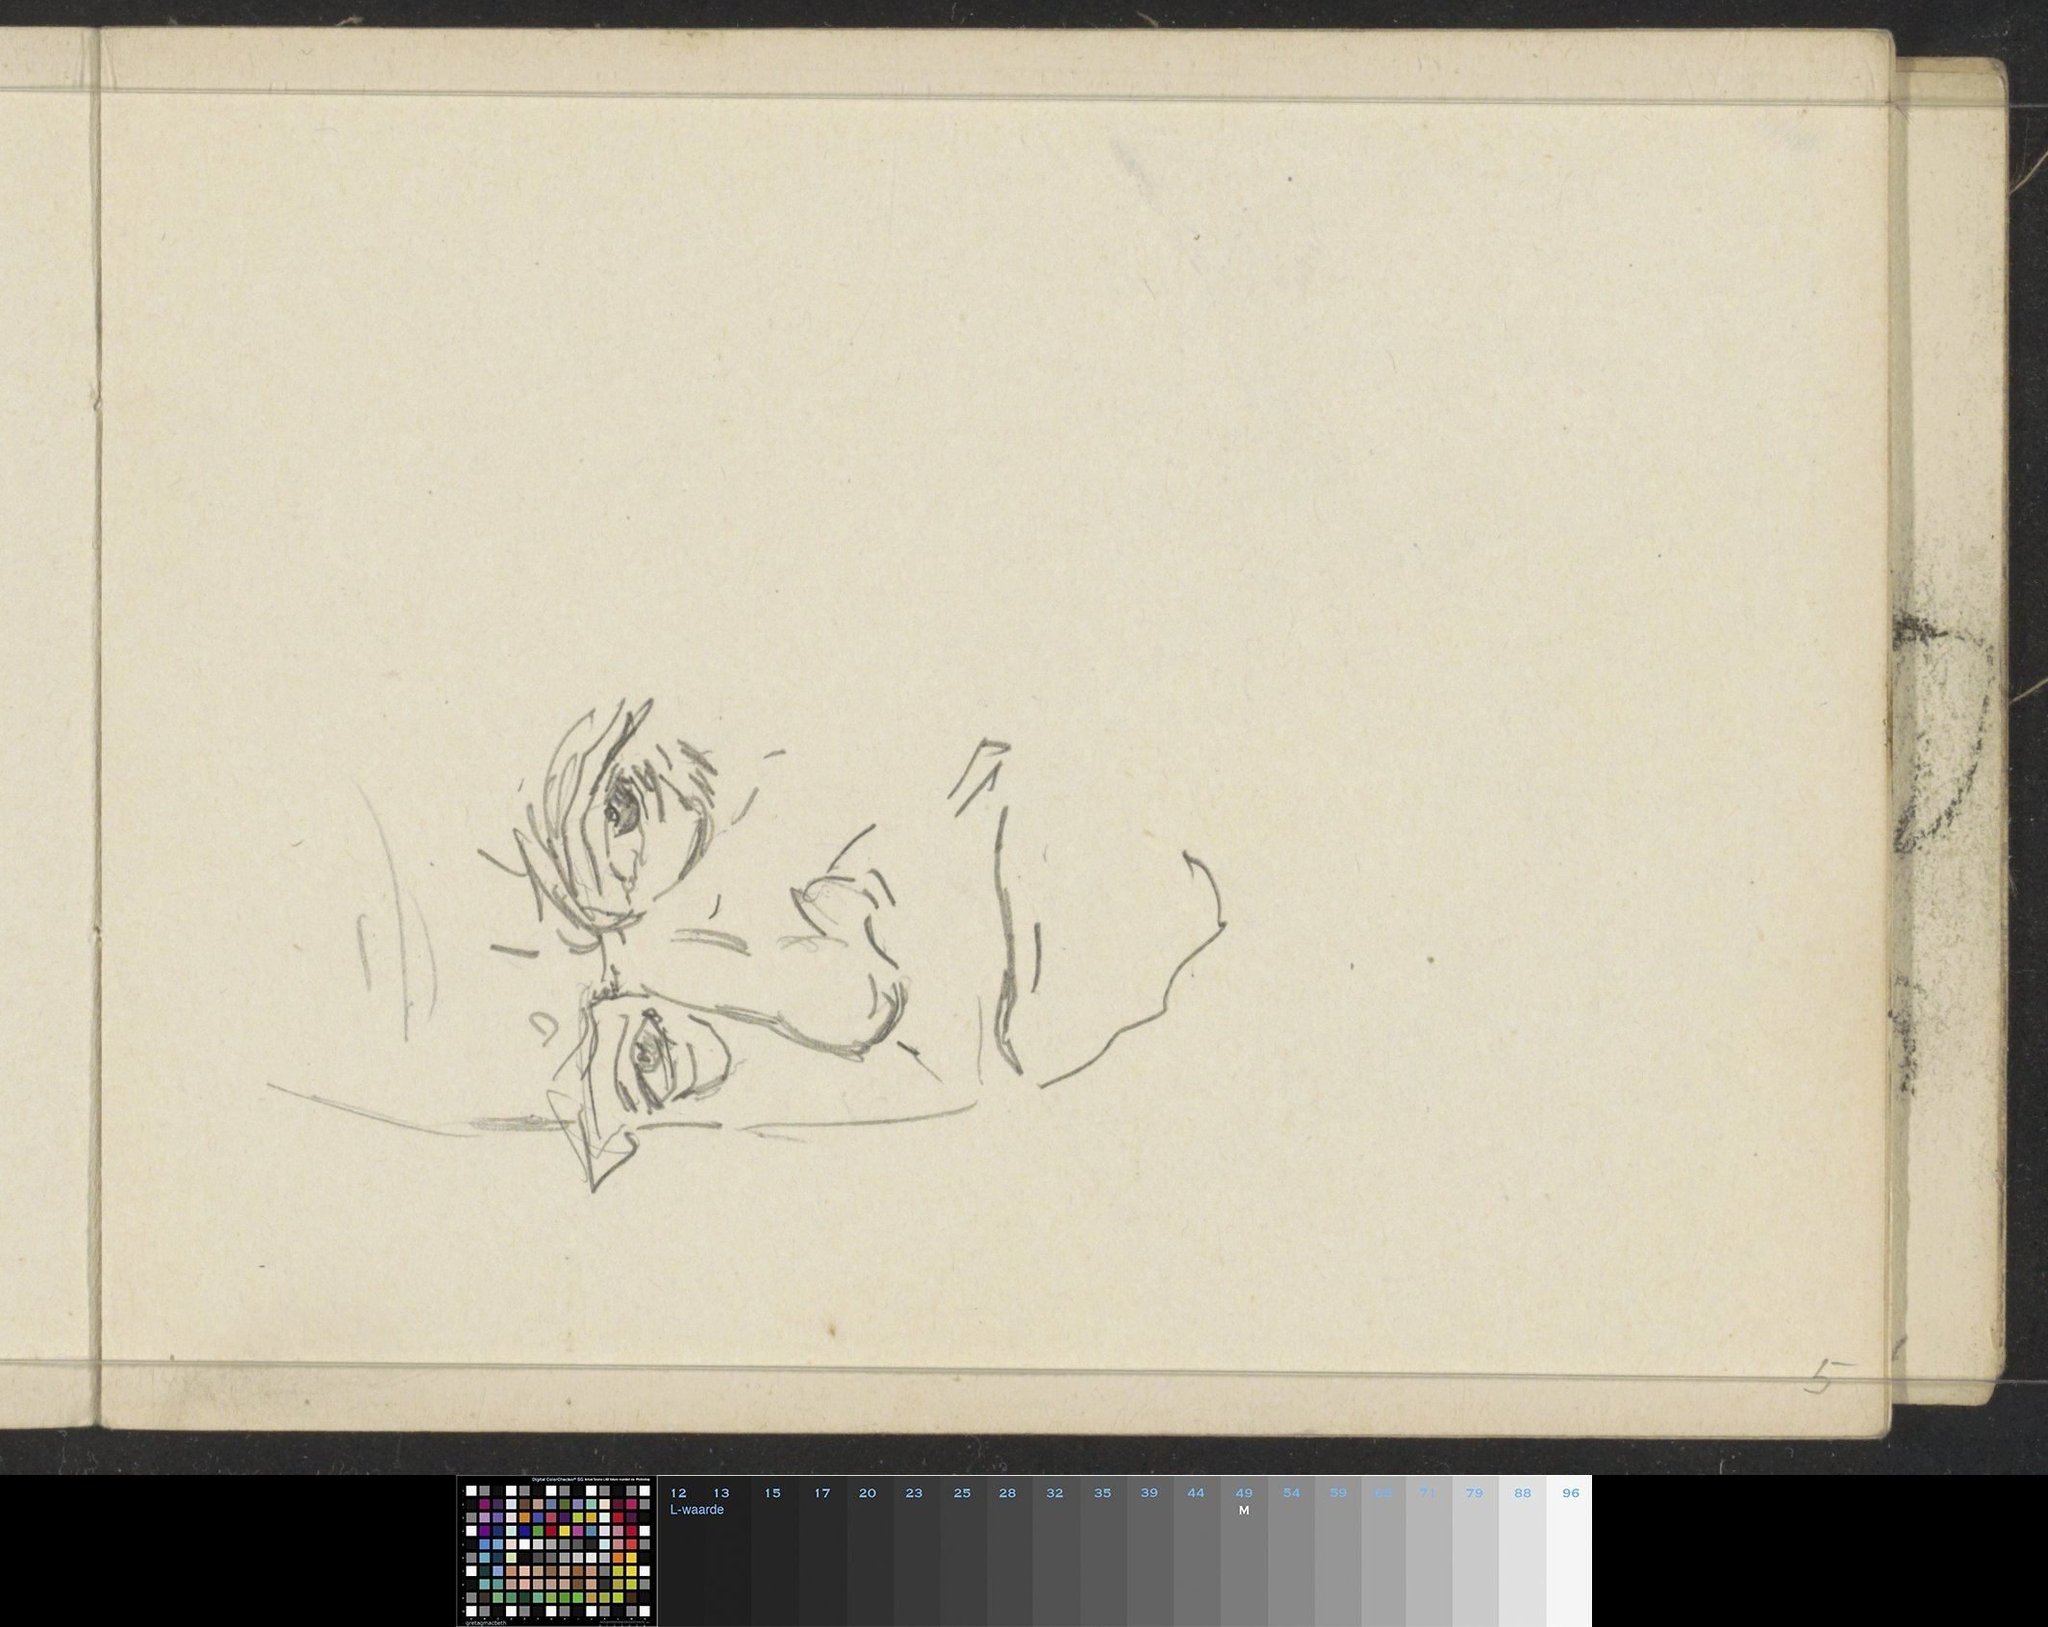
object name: sketchbook leaf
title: Zelfportret van Isaac Israels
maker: isaac israels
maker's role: draughtsman, painter, print maker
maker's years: 1865-1934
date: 1923-1934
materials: paper, pencil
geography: the hague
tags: amsterdam, the hague, painter, print maker, draughtsman, isaac israels, portrait, self-portrait of artist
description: Blad 5 recto uit schetsboek LVIII met 14 bladen.